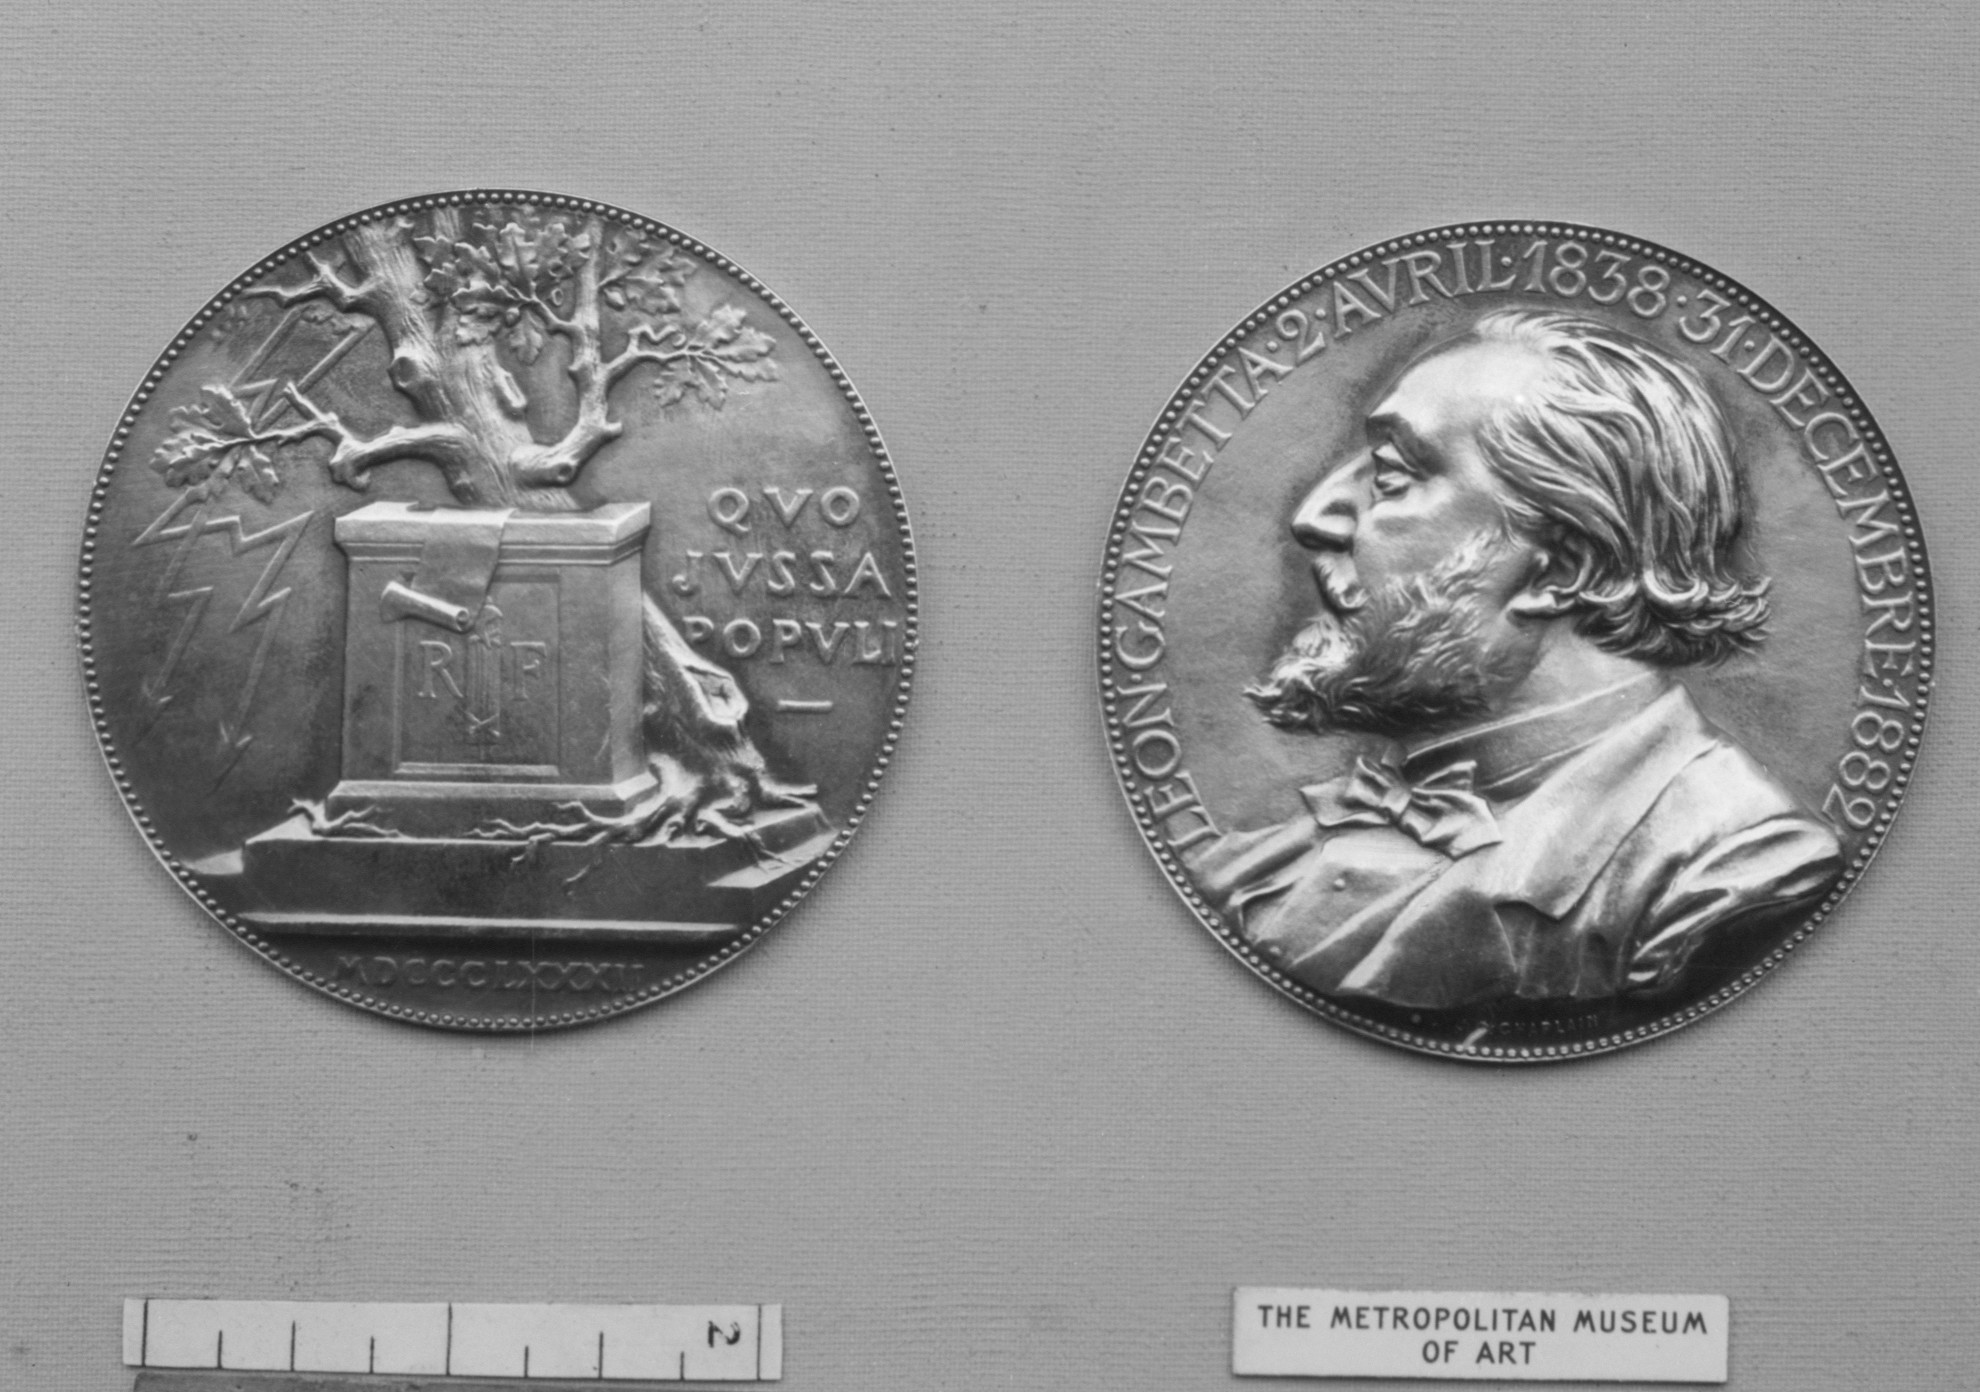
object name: medal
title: In Memory of Leon Gambetta, French Politician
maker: jules-clément chaplain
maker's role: artist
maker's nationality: french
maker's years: 1839-1909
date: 1882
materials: bronze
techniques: silvered, struck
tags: men,profiles,trees